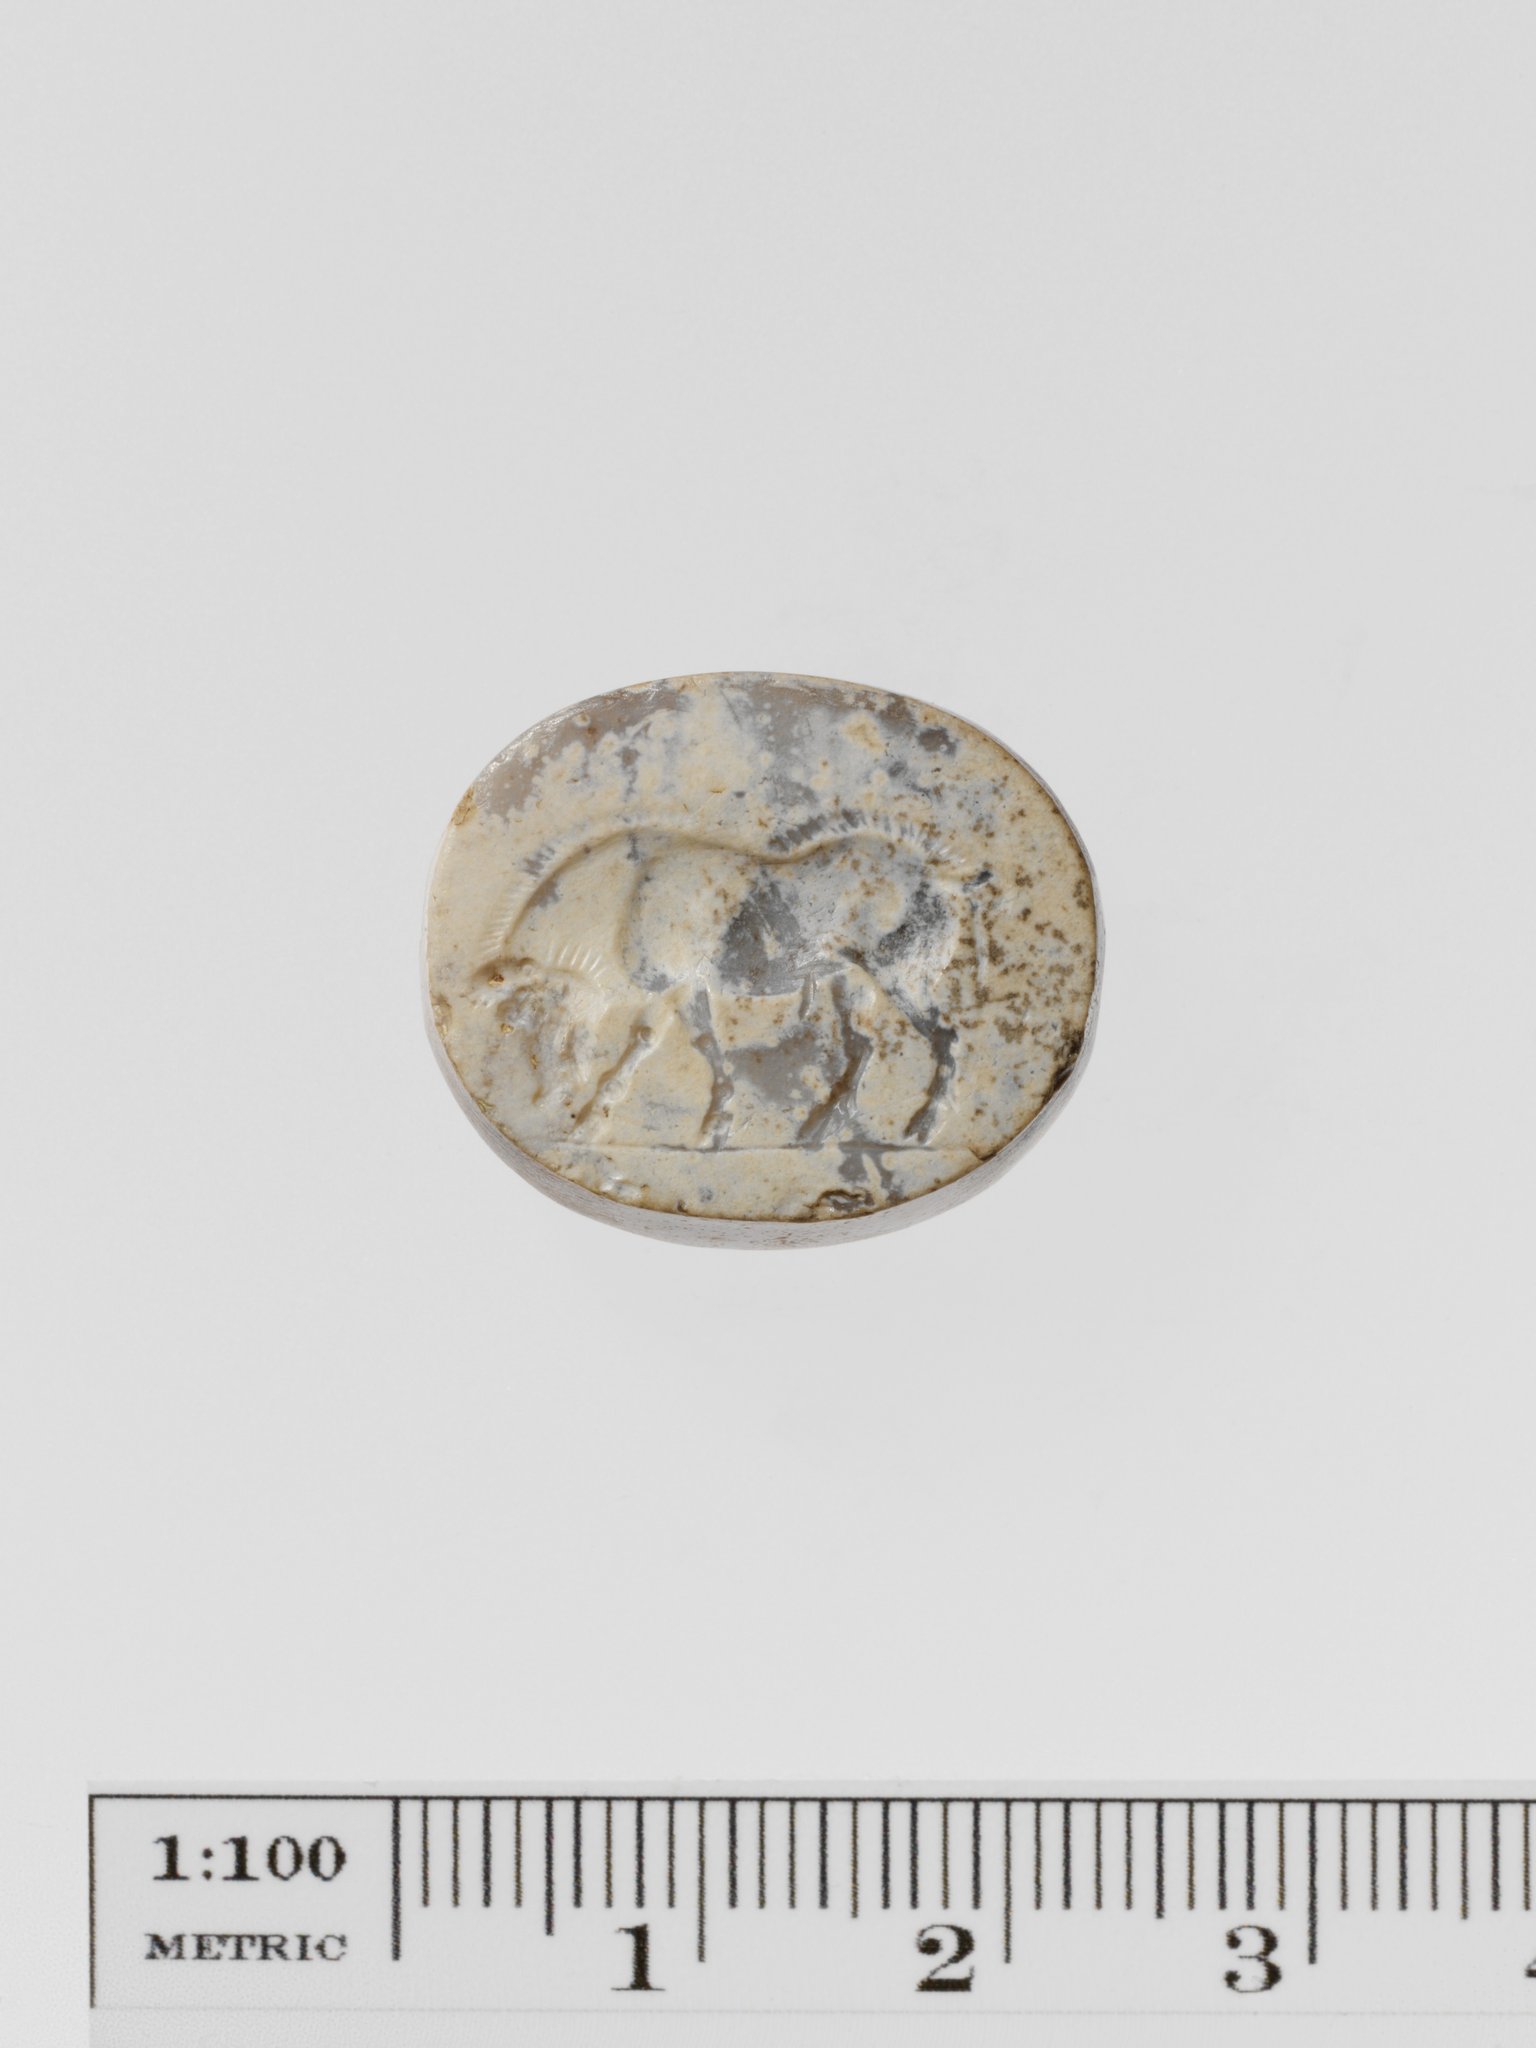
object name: scaraboid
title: Chalcedony scaraboid seal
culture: greek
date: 500-401 BCE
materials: gemstone, stone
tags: boars